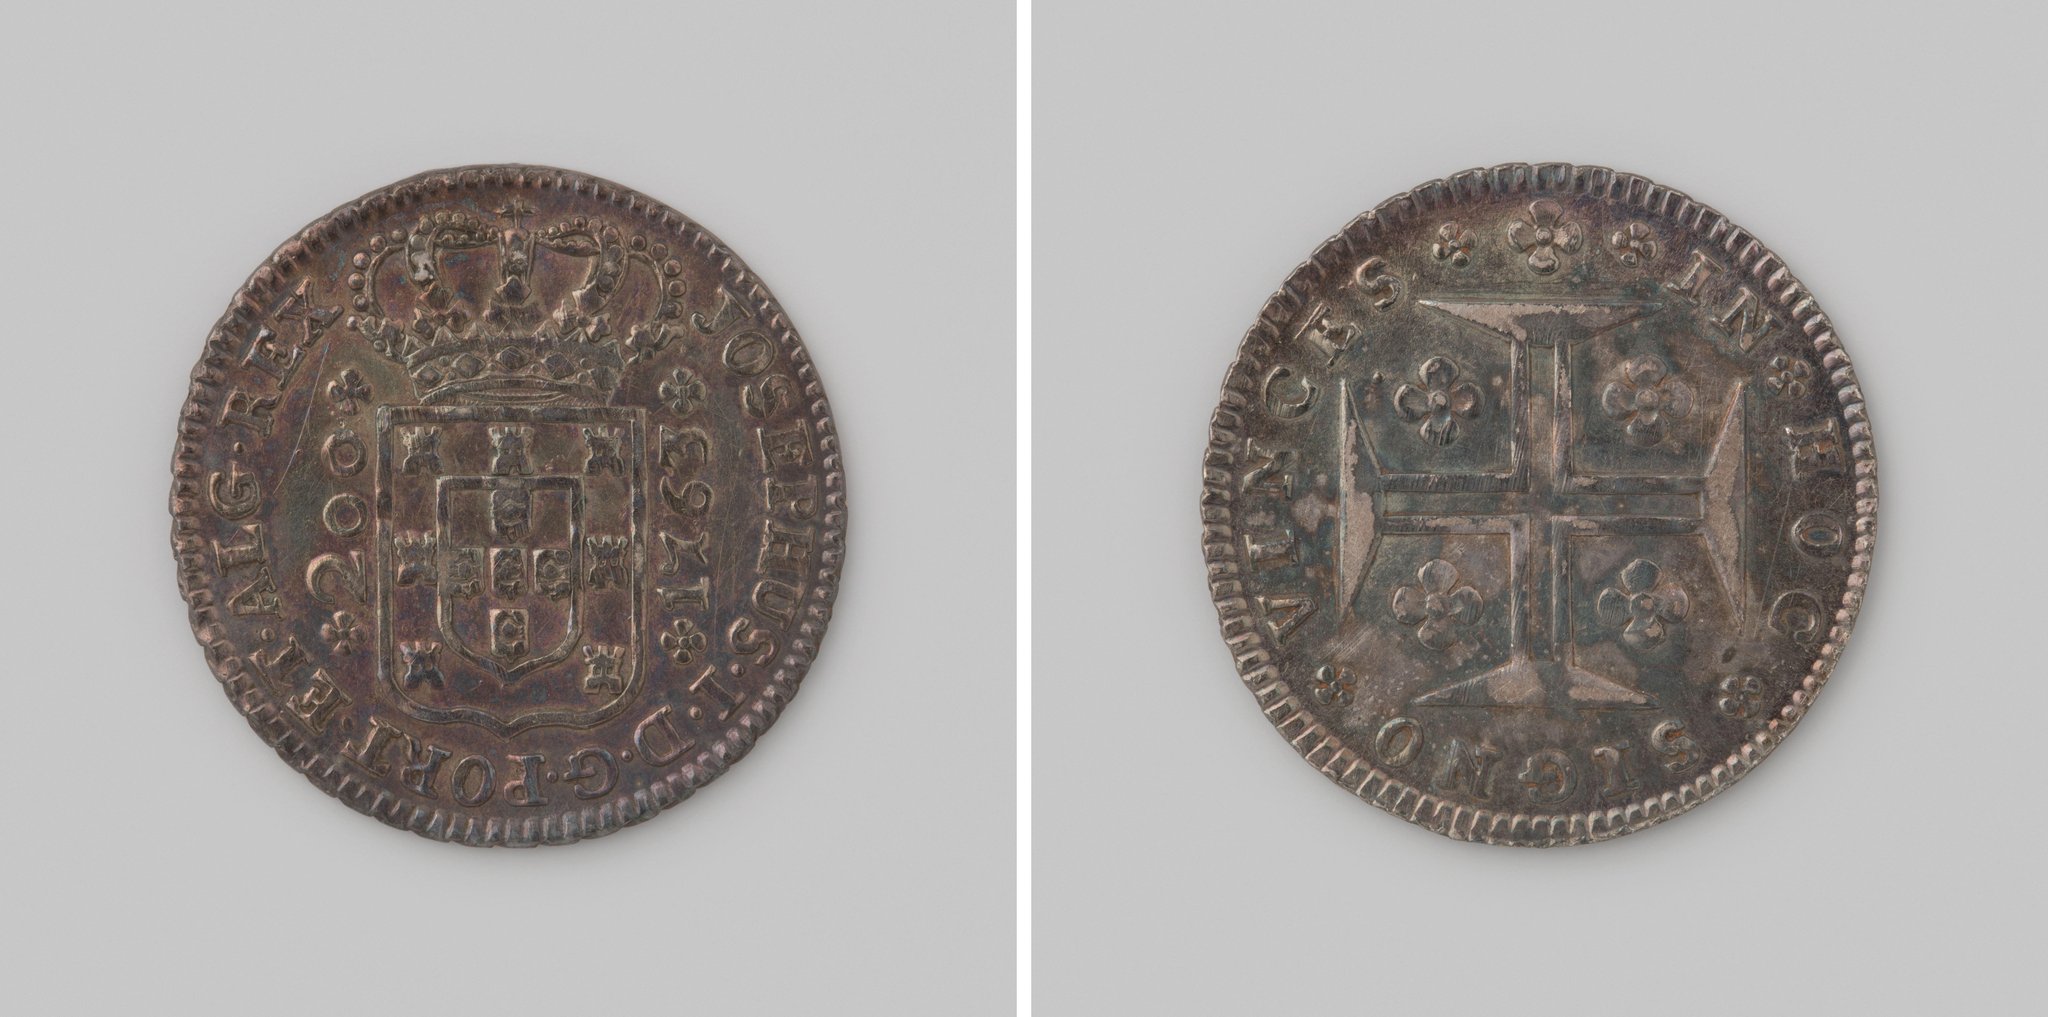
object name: coin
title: ½ cruzado of 200 reis uit Portugal van koning José I,1763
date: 1763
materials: silver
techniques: striking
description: Zilveren munt. Voorzijde: gekroond wapenschild, links daarvan waarde-aanduiding: 200, rechts daarvan jaartal. Keerzijde: kort gevoet kruis, met in de hoeken roosjes. Bloemrand.